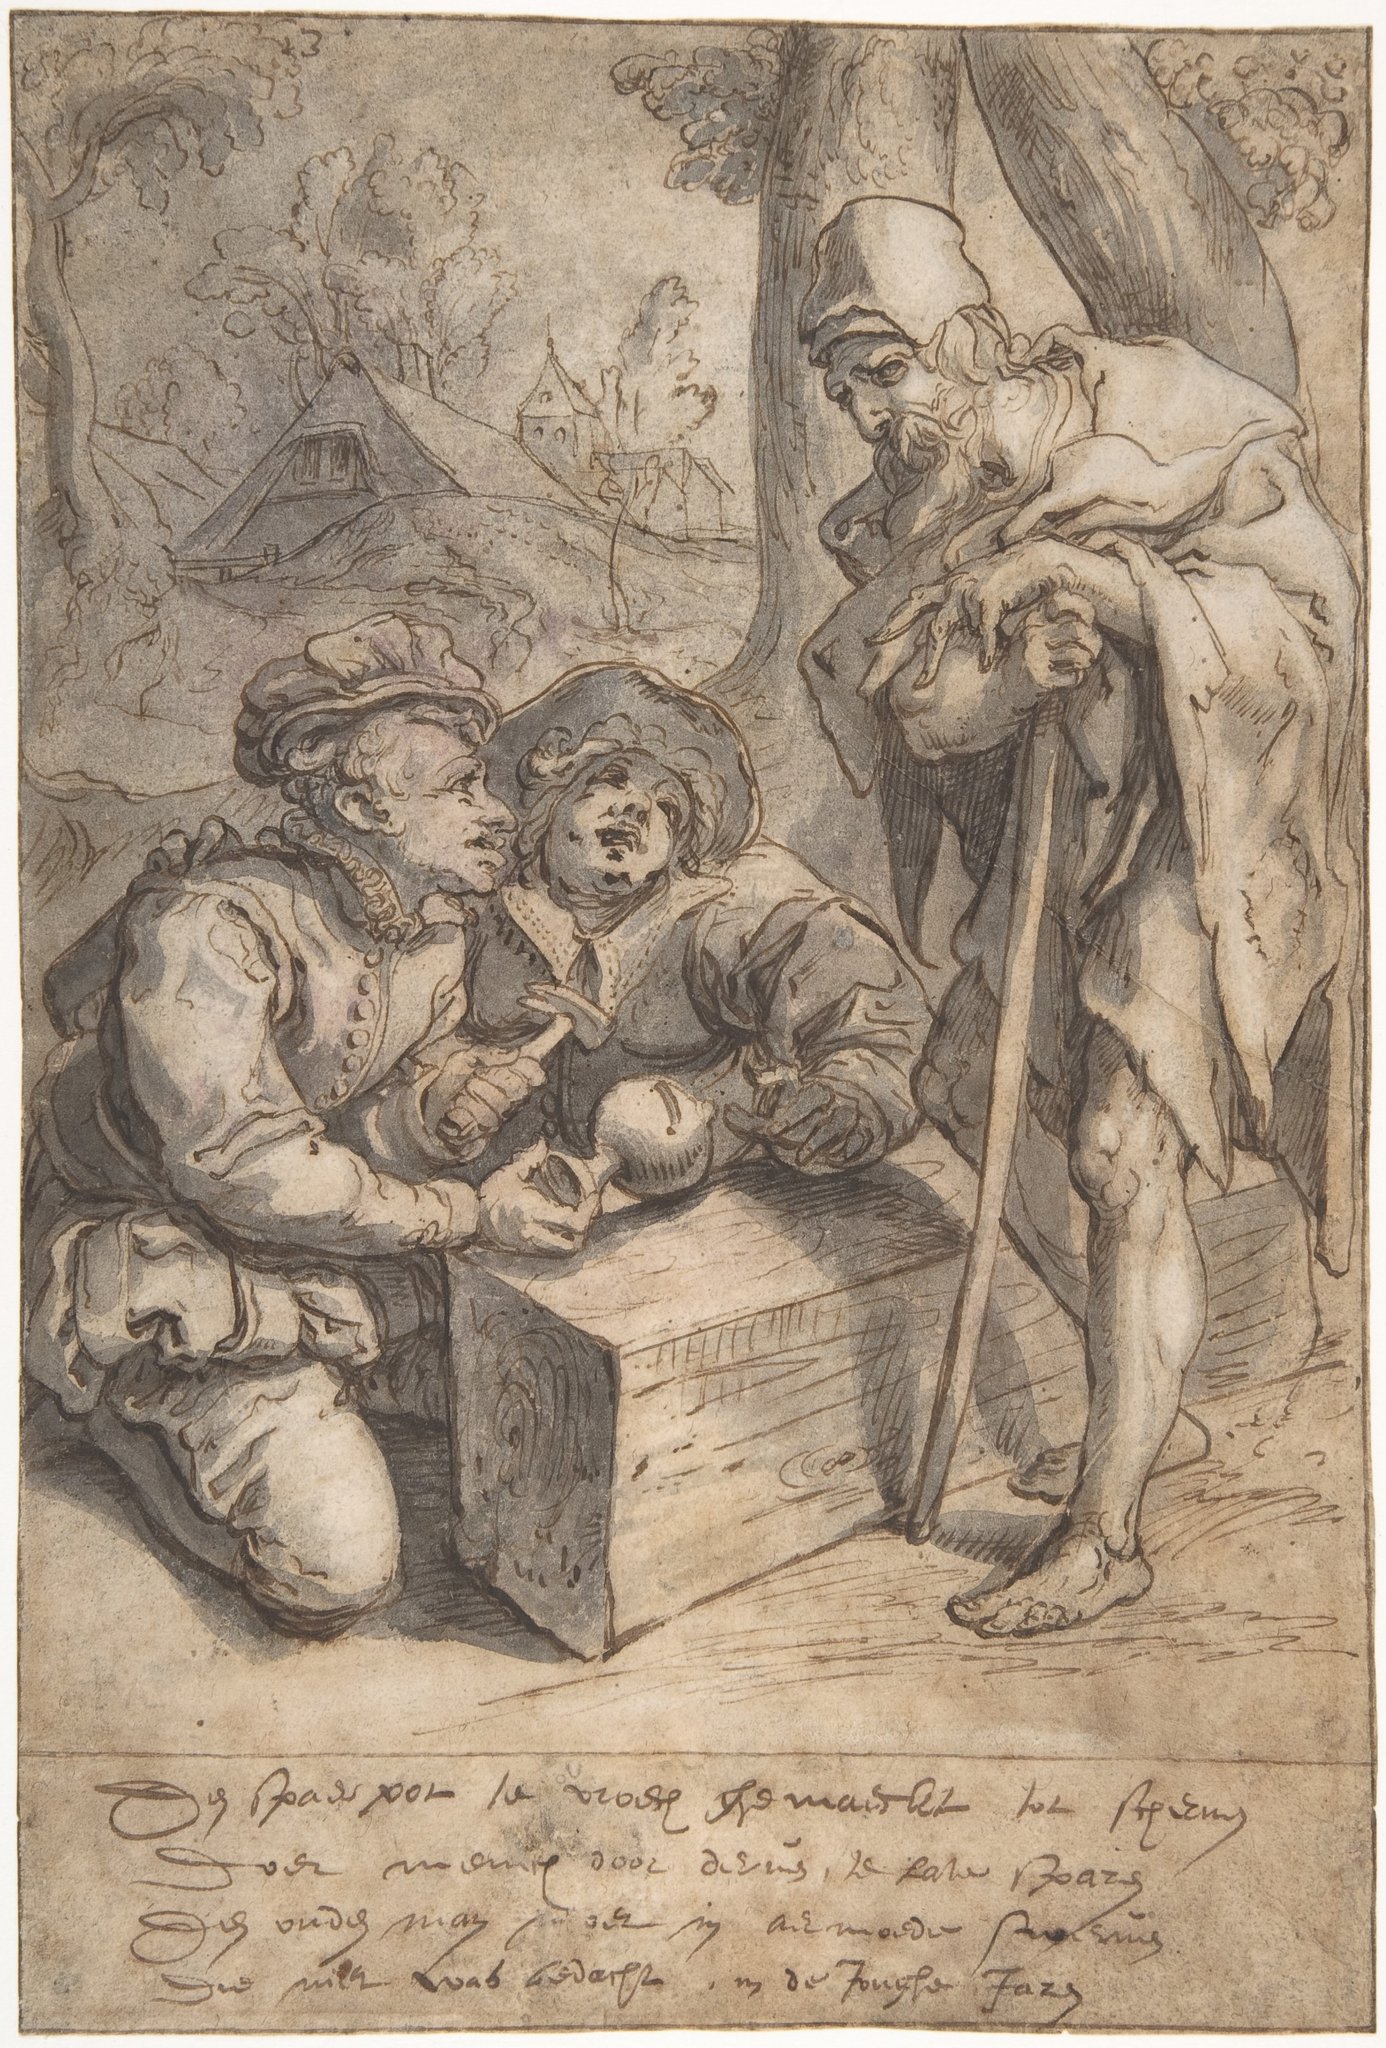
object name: drawing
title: A Proverb: Wealth and Poverty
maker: karel van mander (i)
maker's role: artist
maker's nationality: netherlandish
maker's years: 1548-1606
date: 1534-1633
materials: ink, paper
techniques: heightening, pen, wash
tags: houses,men,women,trees